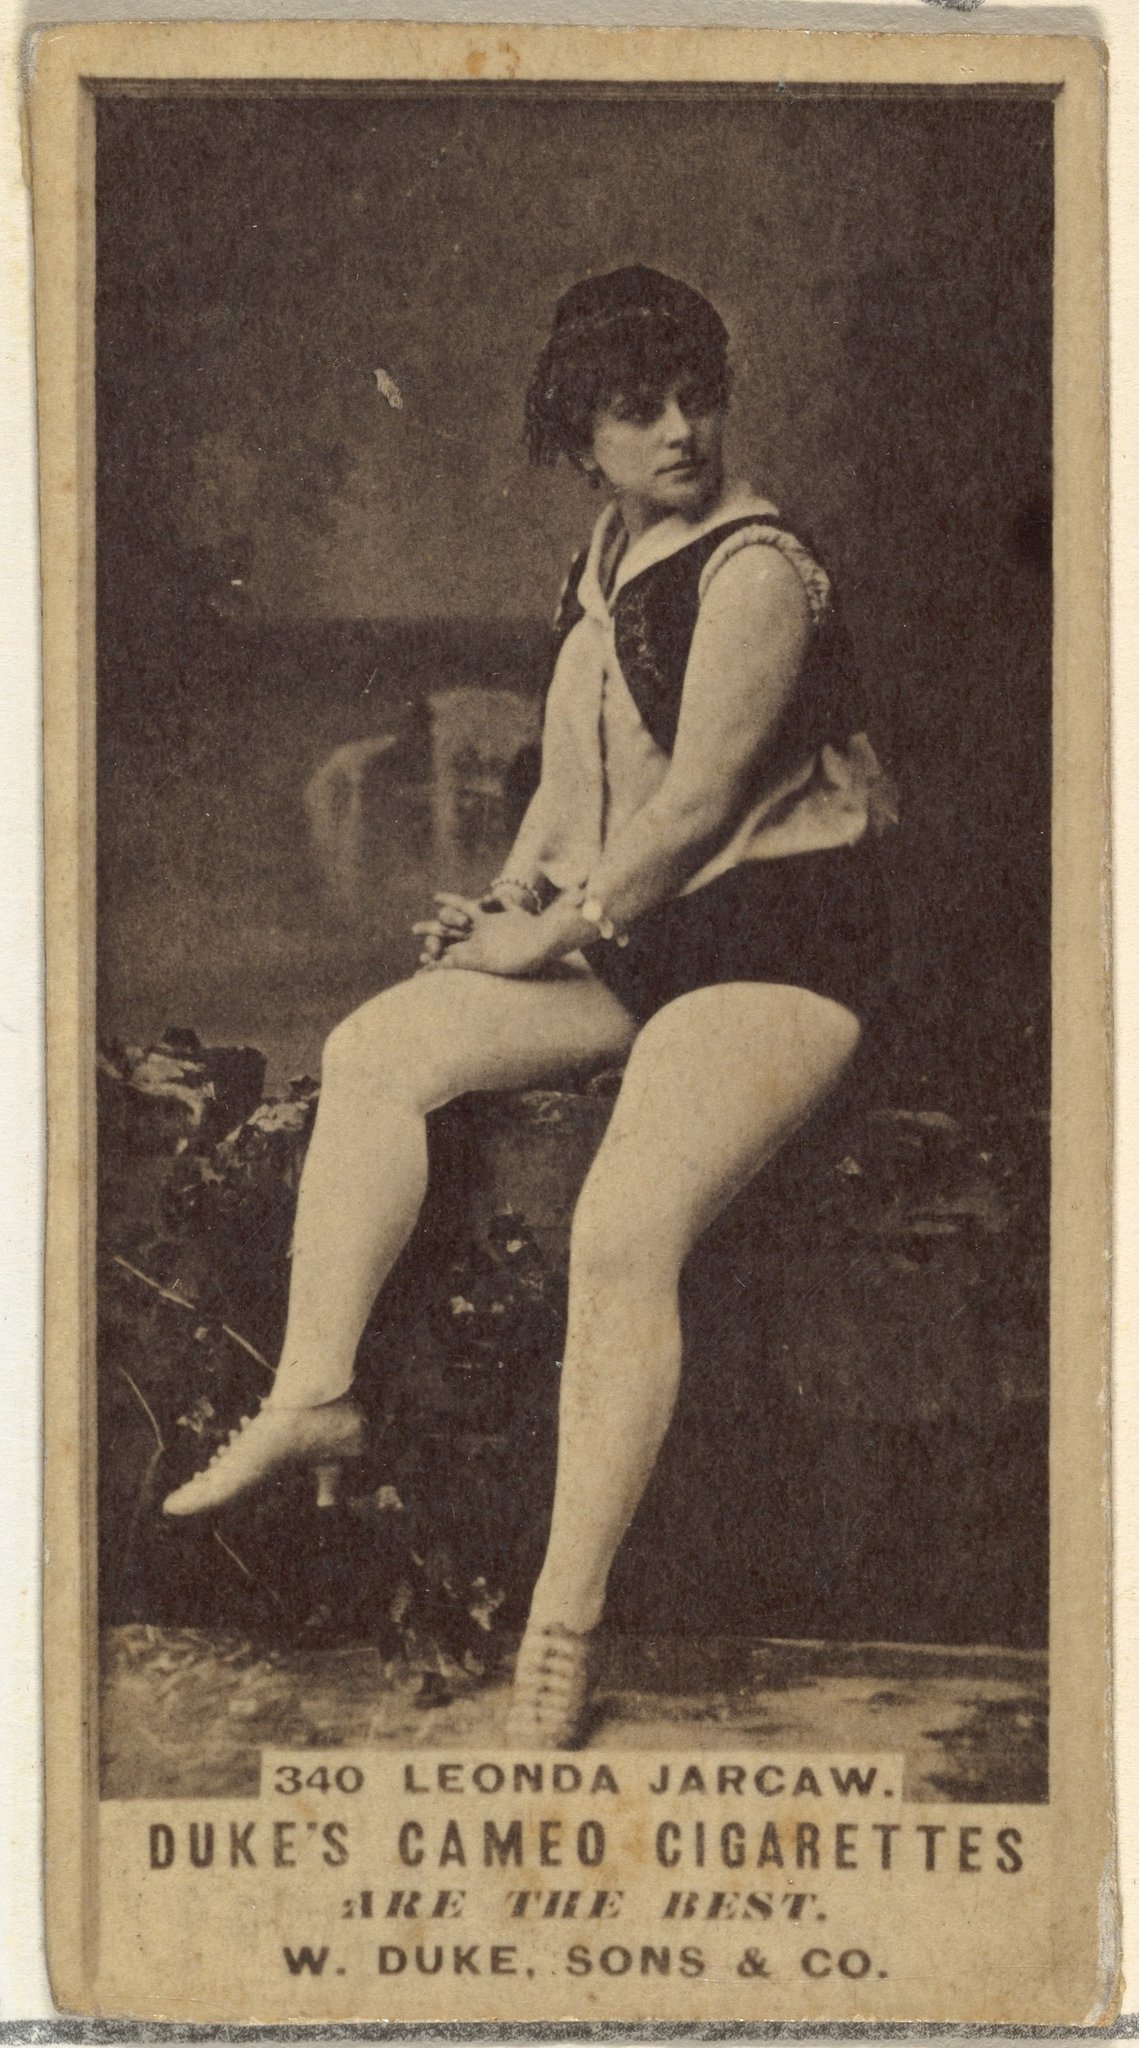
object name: photograph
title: Card Number 340, Leonda Jarcaw, from the Actors and Actresses series (N145-5) issued by Duke Sons & Co. to promote Cameo Cigarettes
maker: w. duke, sons & co.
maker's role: publisher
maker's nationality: american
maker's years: 1870-1920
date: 1880-1889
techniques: albumen silver print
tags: portraits,women,actresses